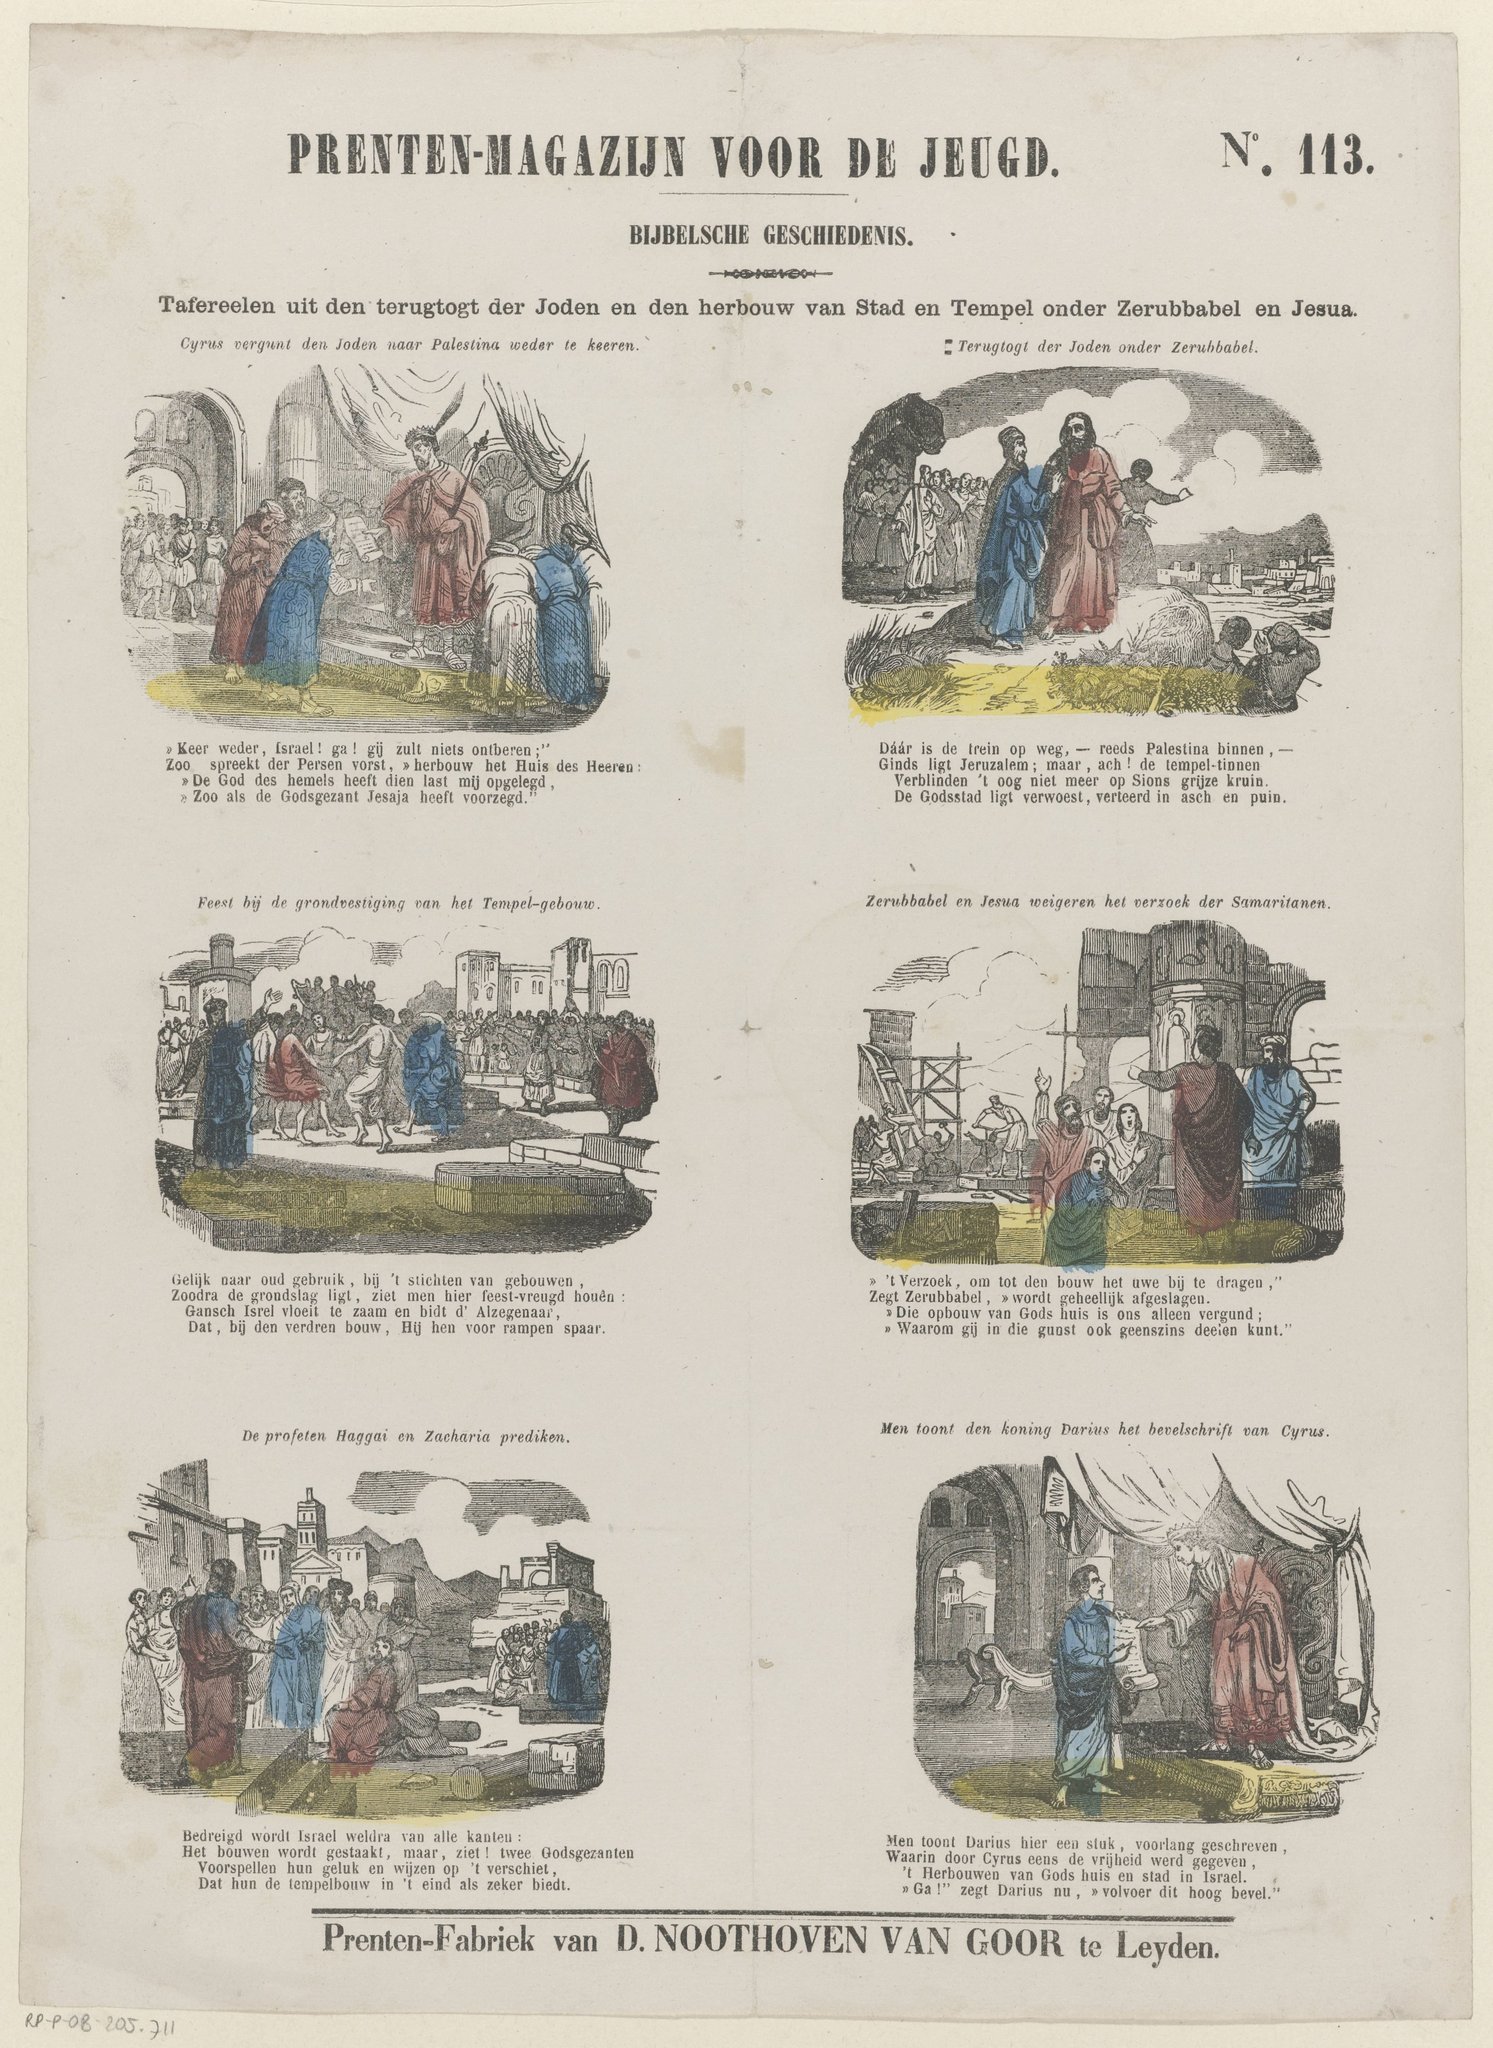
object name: print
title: Bijbelsche geschiedenis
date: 1850-1881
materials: paper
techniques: colour, letterpress printing, engraving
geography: netherlands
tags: exhorted by the prophets haggai and zechariah, zerubbabel and jeshua resume the rebuilding of the temple, under the leadership of sheshbazzar (zerubbabel) the jews return to their country, zerubbabel and jeshua (joshua) refuse to let the samaritans help rebuild the temple, old testament, (story of) darius, king of persia, (story of) cyrus king of persia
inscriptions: collector's mark: Lugt 2760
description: Blad met 6 voorstellingen van verhalen uit het Oude Testament. Boven elke afbeelding een titel, onder elke afbeelding een vierregelig vers. Genummerd rechtsboven: No. 113.